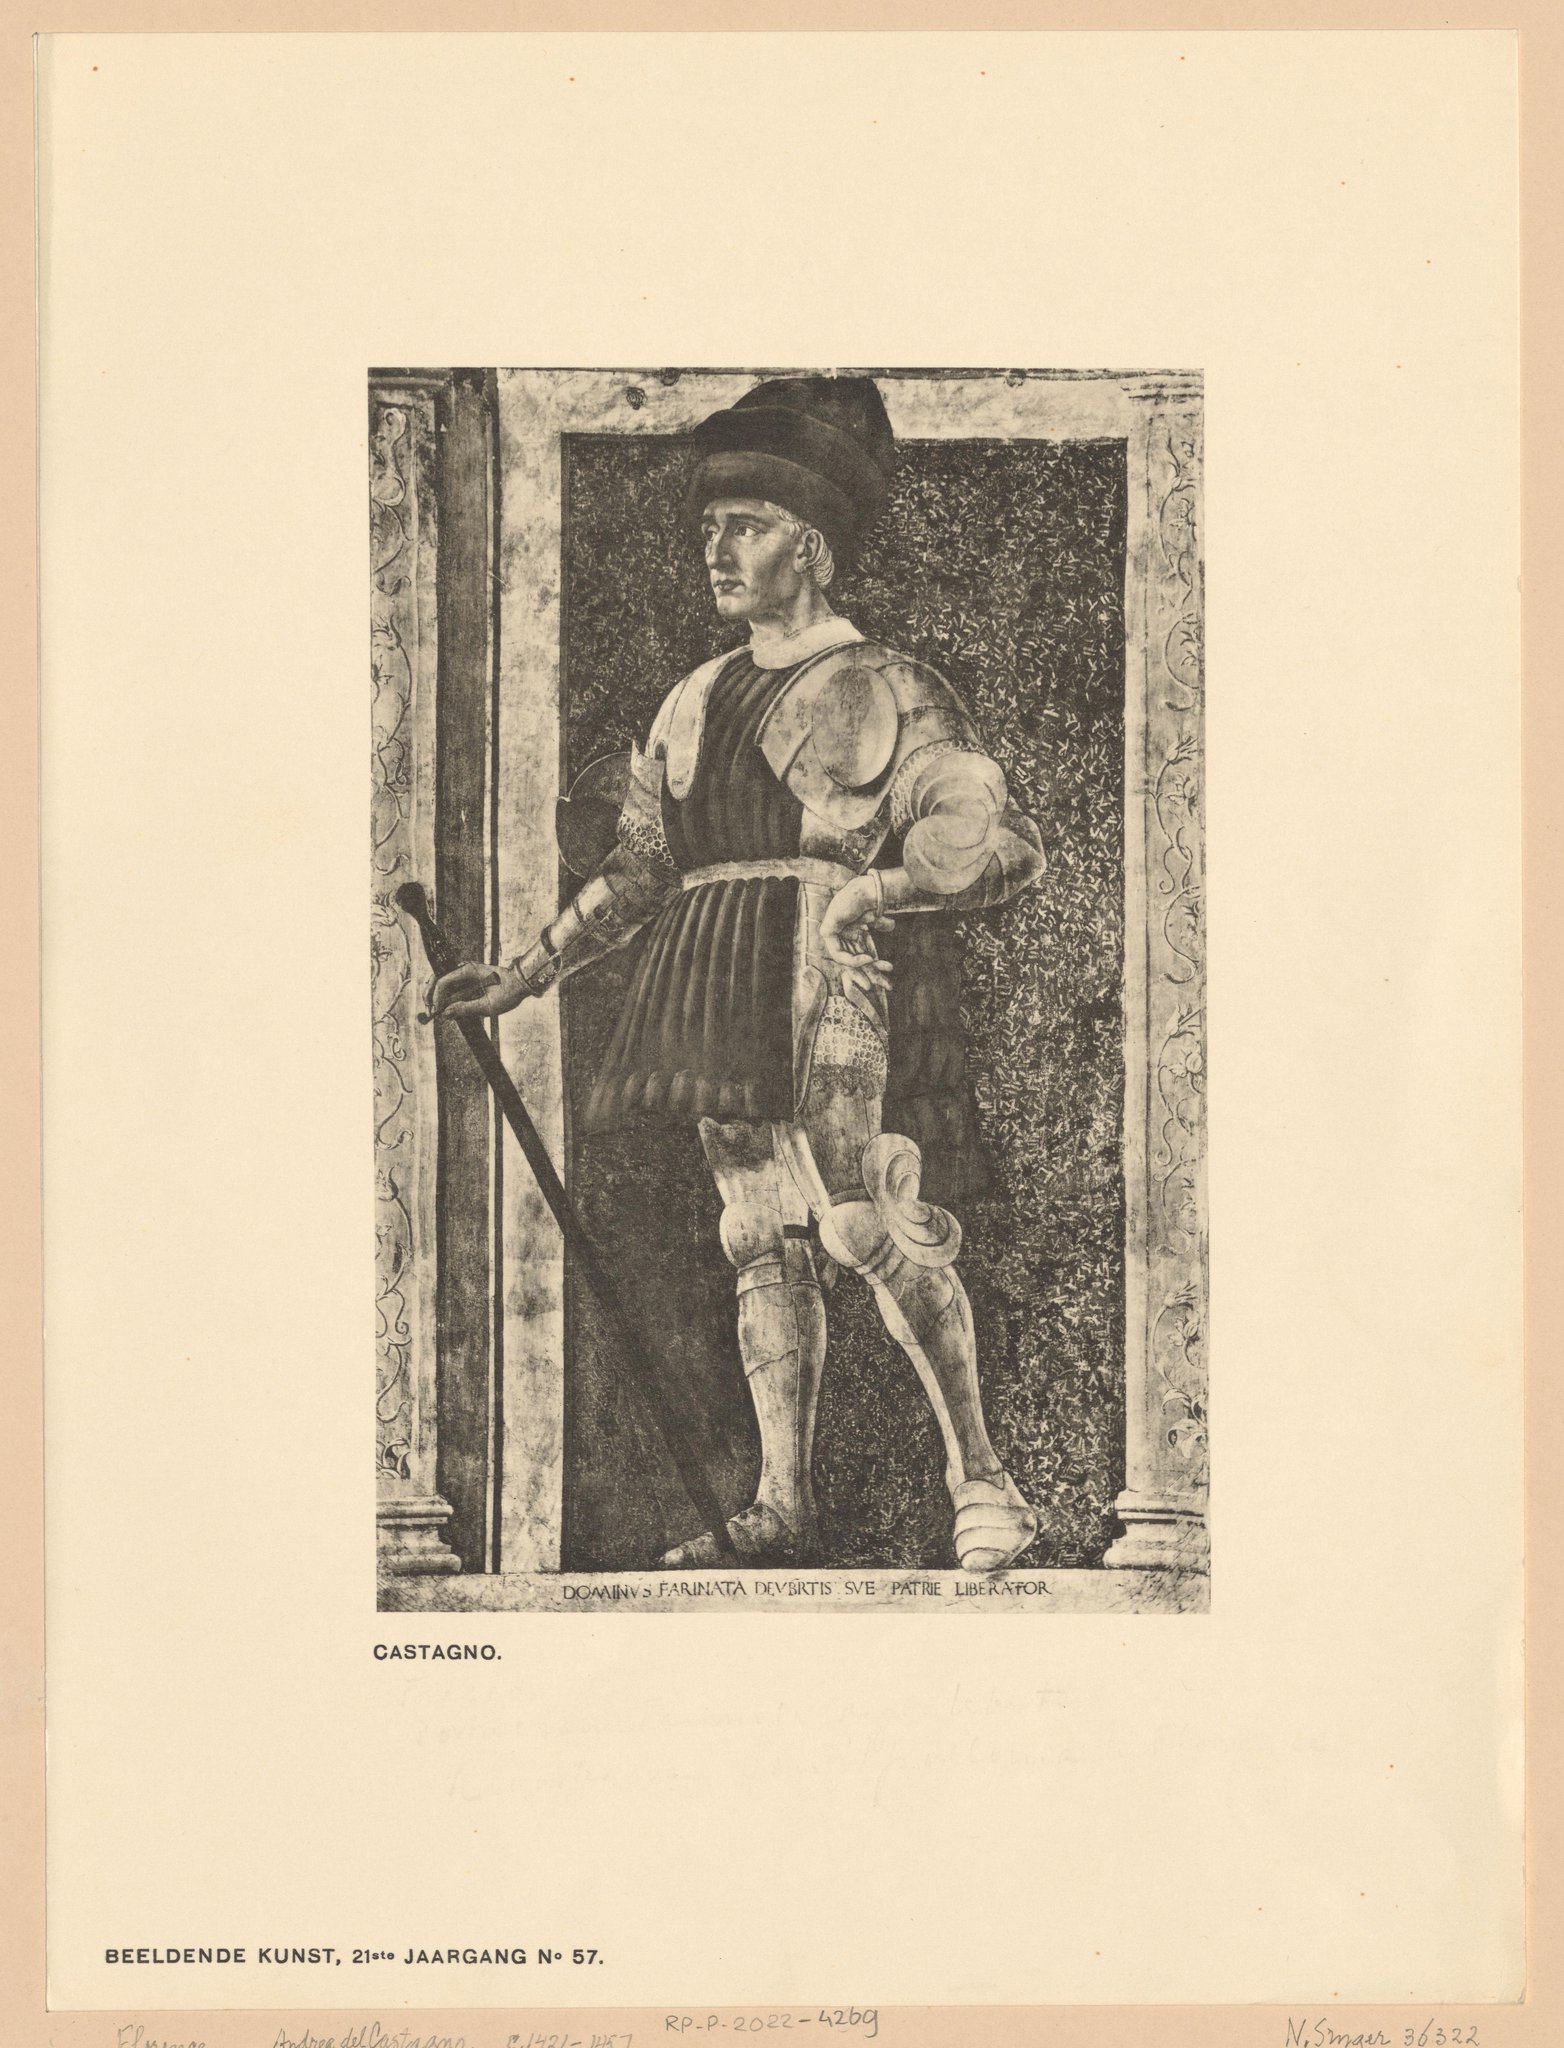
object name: photomechanical print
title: Portret van Farinata degli Uberti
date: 1934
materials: paper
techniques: photograph, letterpress printing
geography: florence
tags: historical persons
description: Prent uit: Beeldende kunst (1934) jrg. 21, nr. 57.